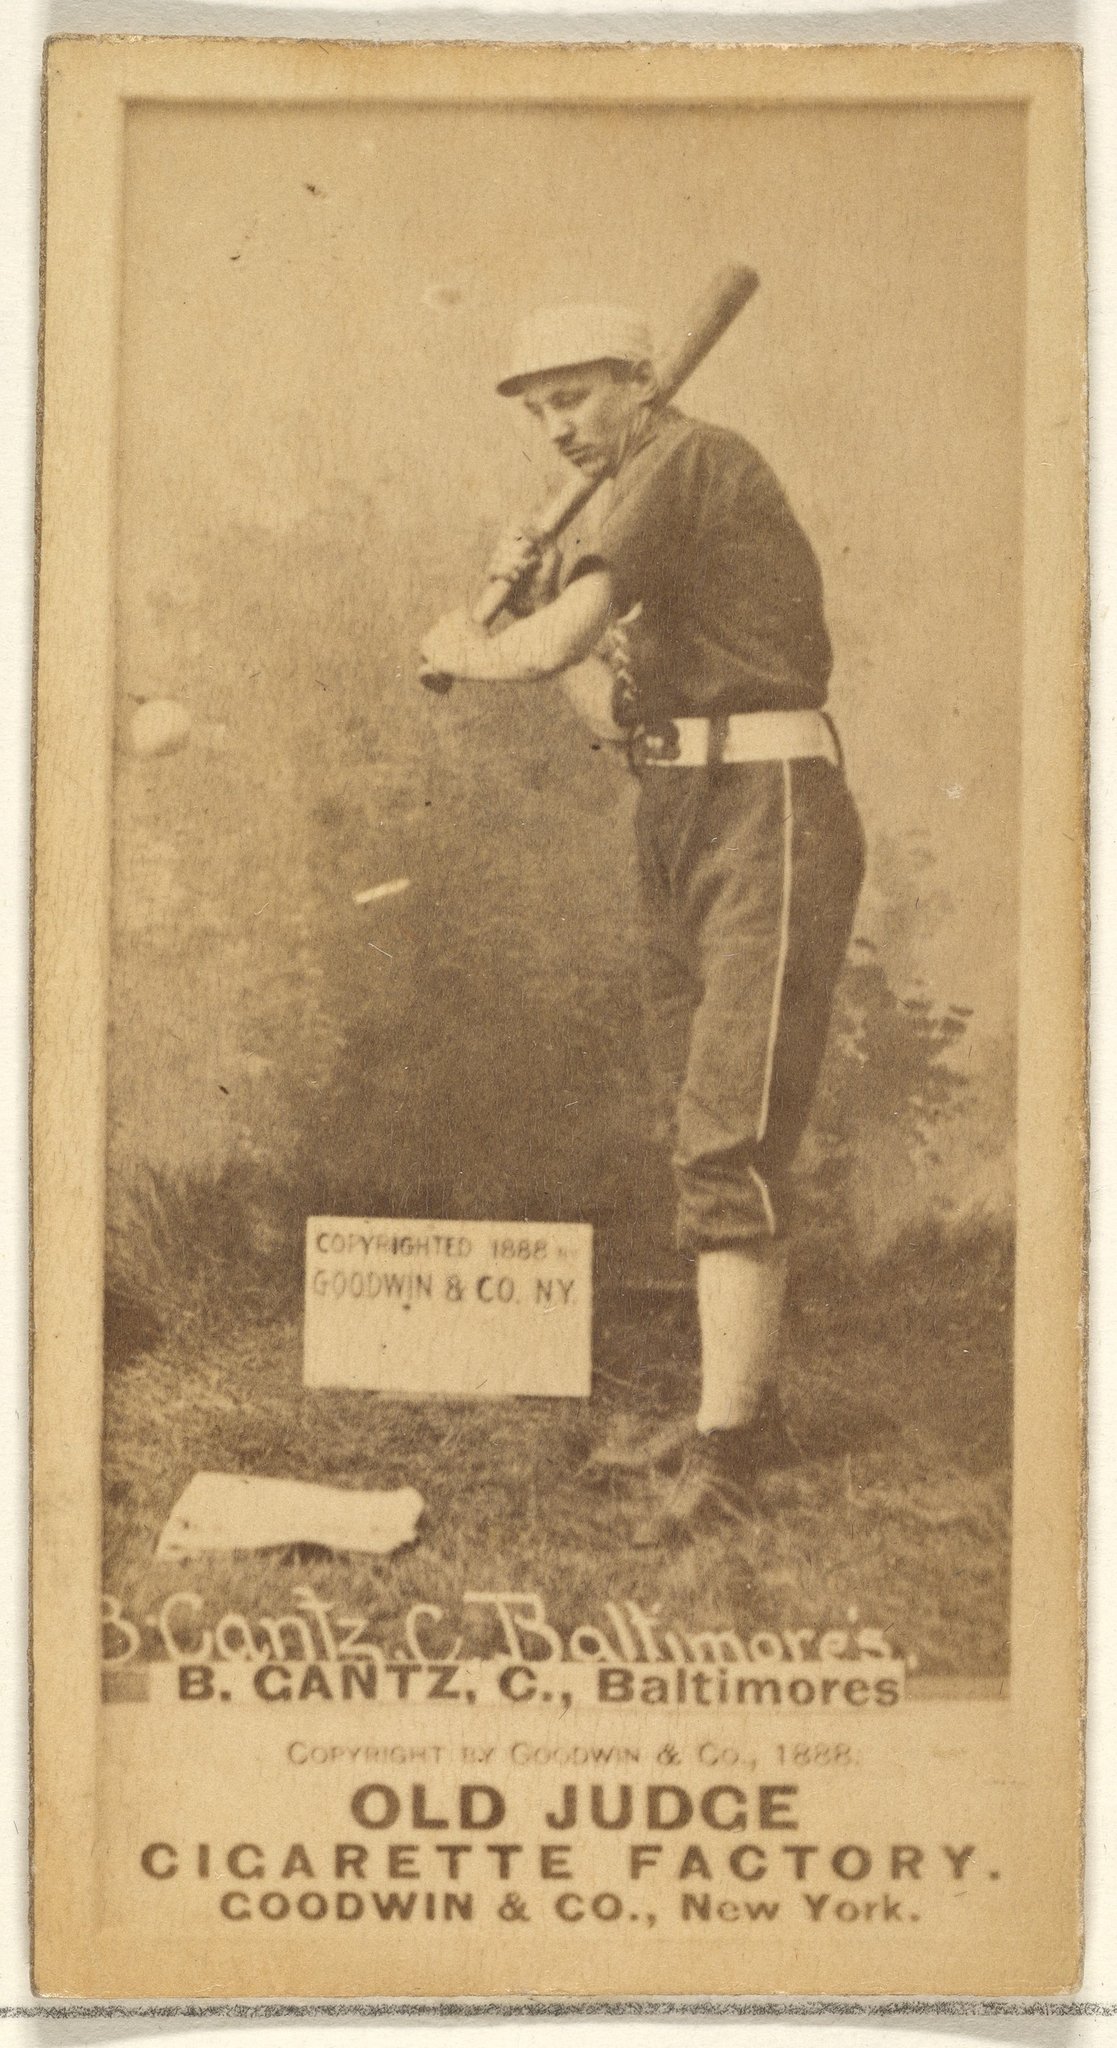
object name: baseball card, photograph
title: Gantz, Catcher, Baltimore Orioles, from the Old Judge series (N172) for Old Judge Cigarettes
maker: goodwin & company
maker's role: publisher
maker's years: 1850-1950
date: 1888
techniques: albumen silver print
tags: men,portraits,baseball,athletes